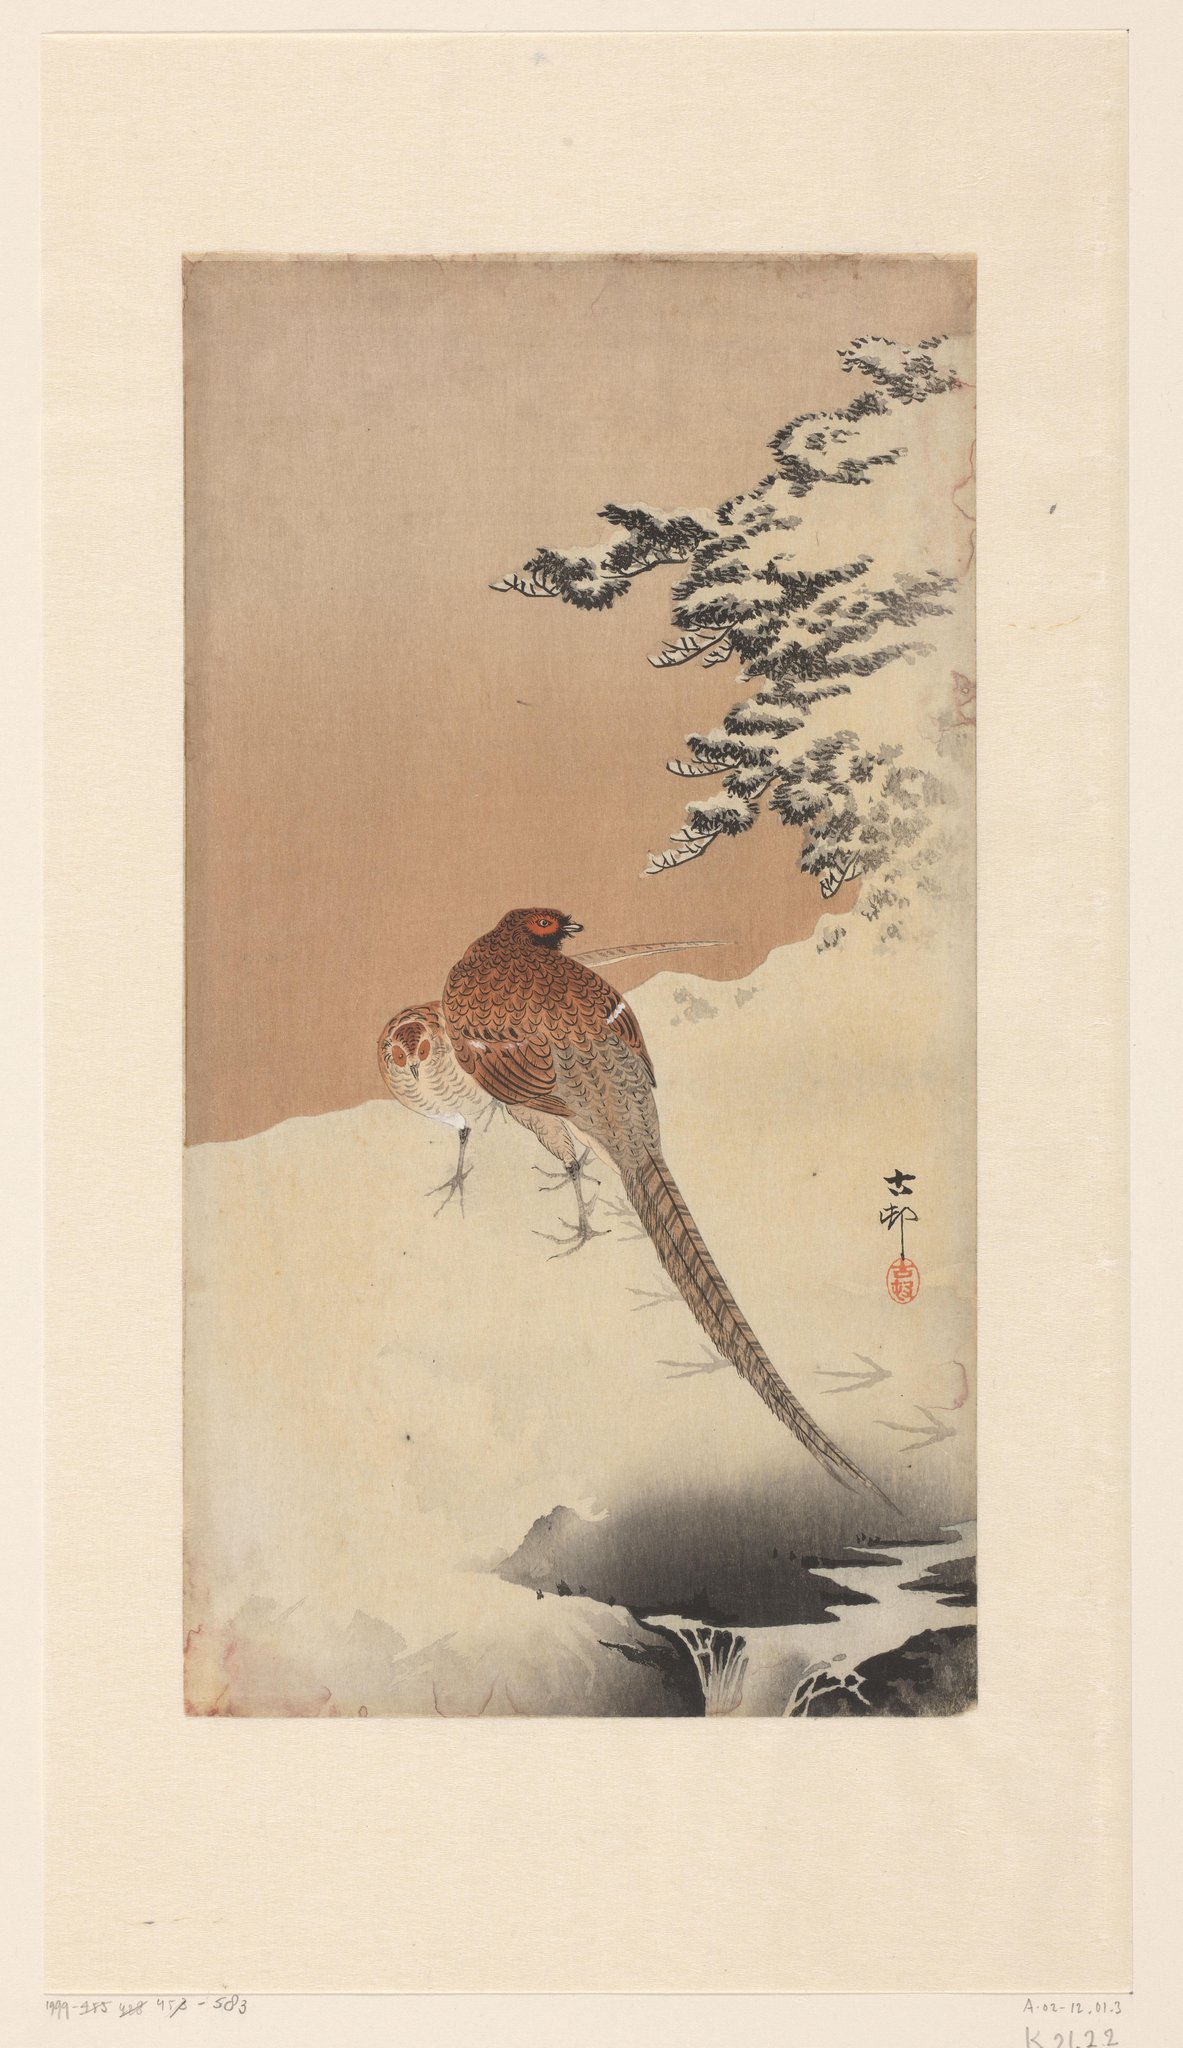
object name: print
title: Fazanten in sneeuw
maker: ohara koson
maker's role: print maker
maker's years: 1877-1945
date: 1900-1930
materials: paper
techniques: woodcut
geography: japan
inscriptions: collector's mark: Lugt 2228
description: Twee fazanten in de sneeuw, poot afdrukken achterlatend; een klein stroompje in de voorgrond.